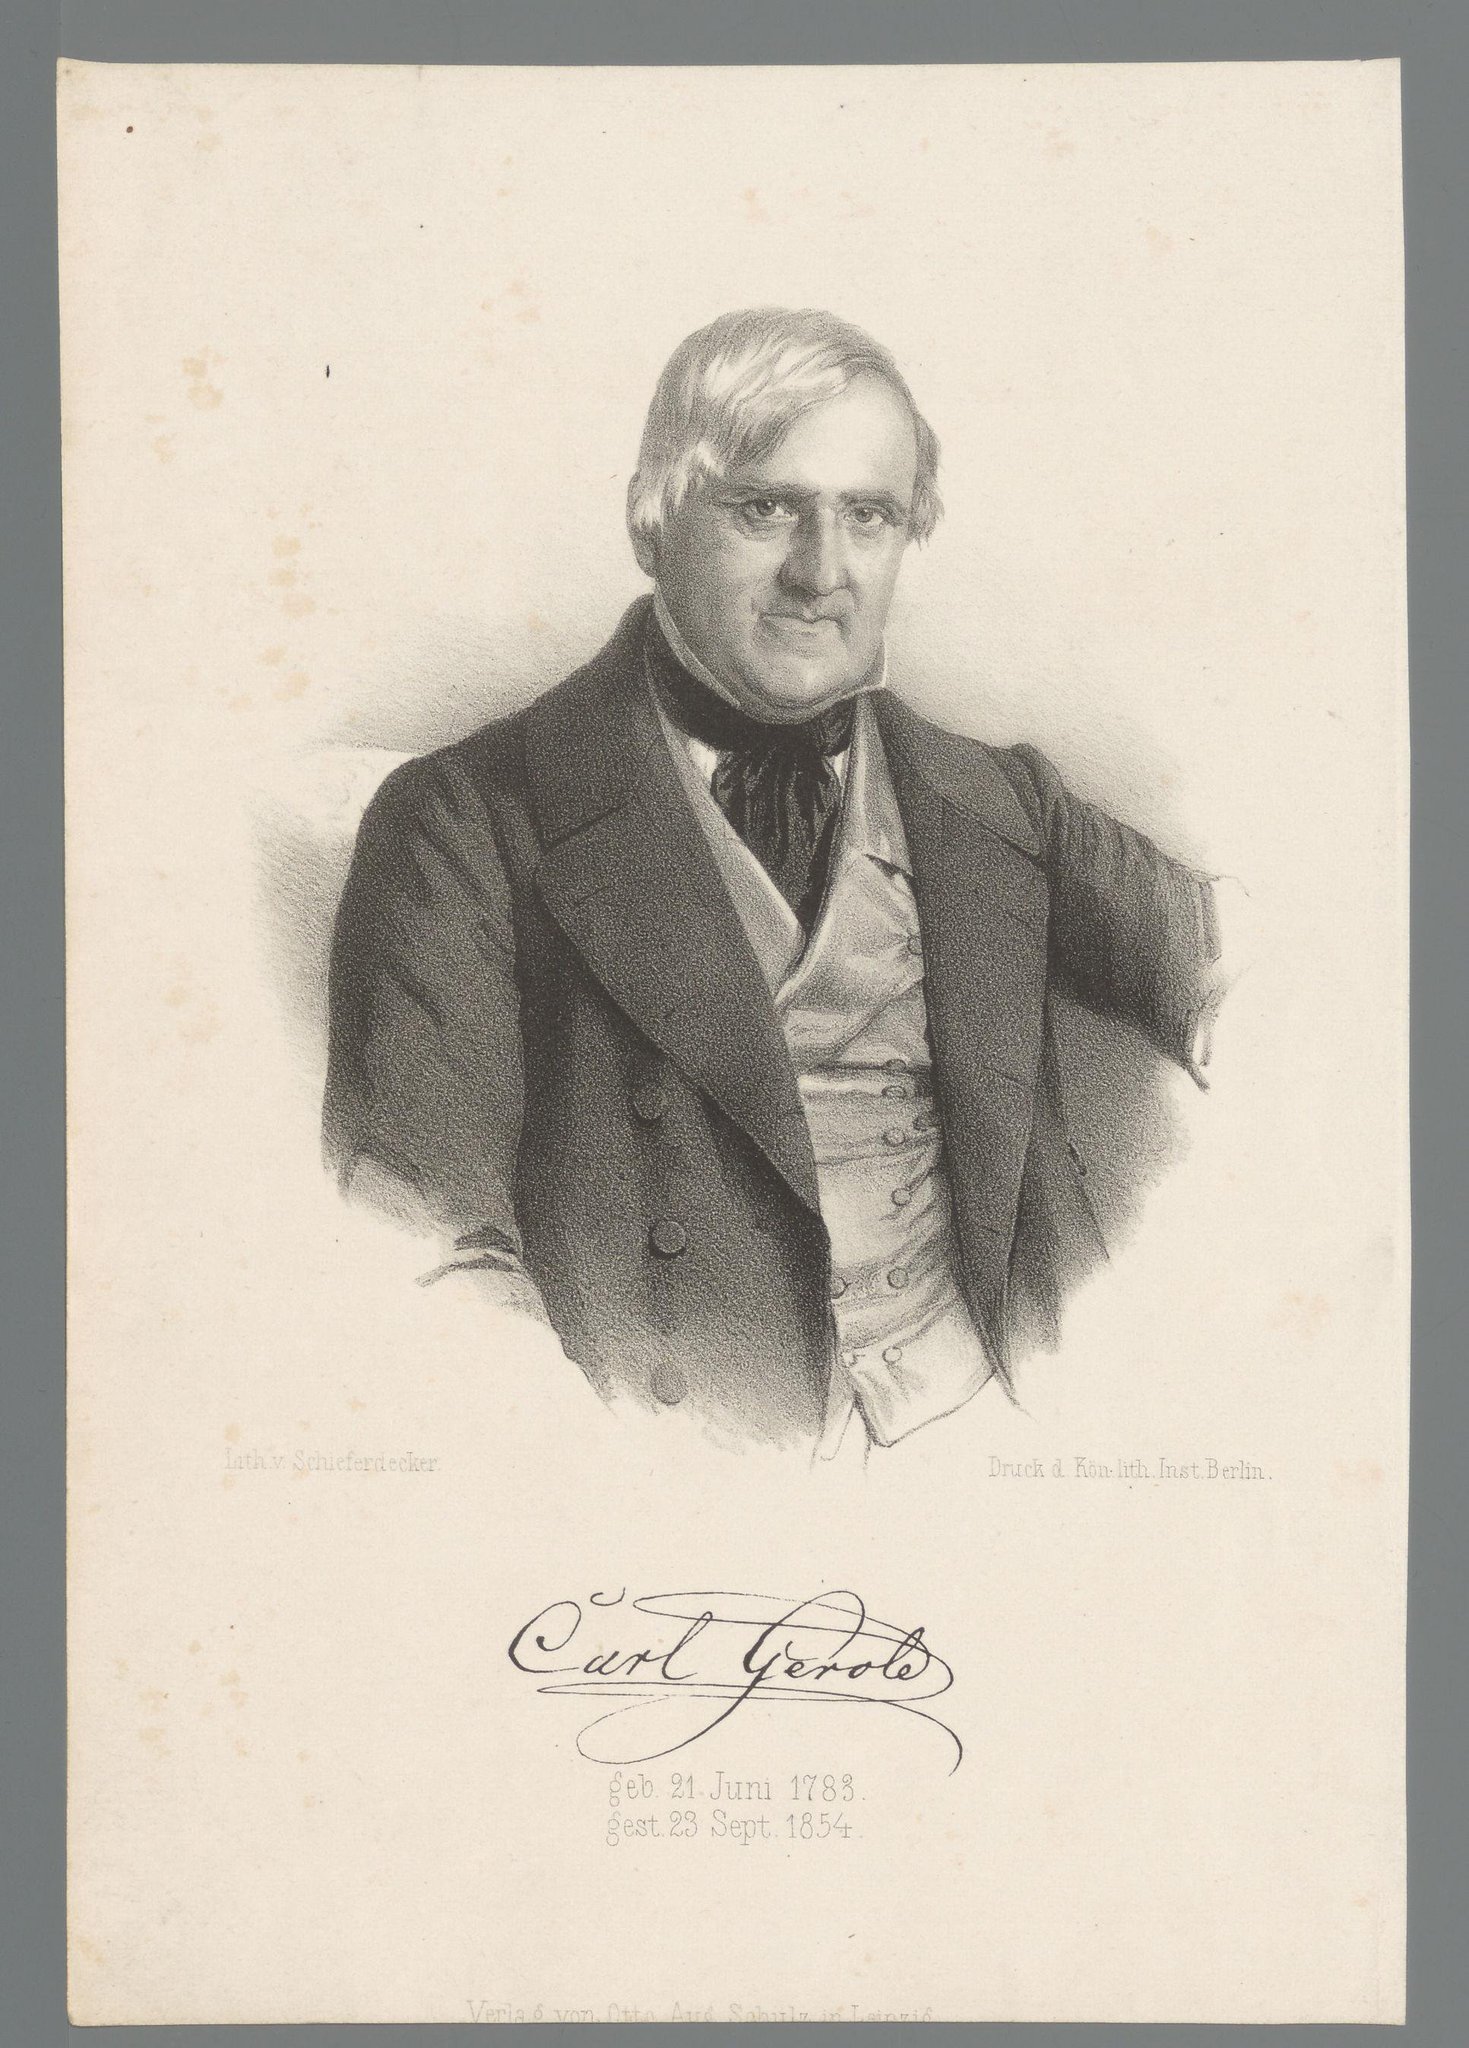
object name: print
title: Portret van Carl Gerold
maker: christian karl august schieferdecker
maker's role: print maker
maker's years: 1823-1878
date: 1833-1878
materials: paper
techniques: lithograph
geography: berlin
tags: vienna, historical persons, publishing, publisher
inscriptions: collector's mark: Lugt 2228